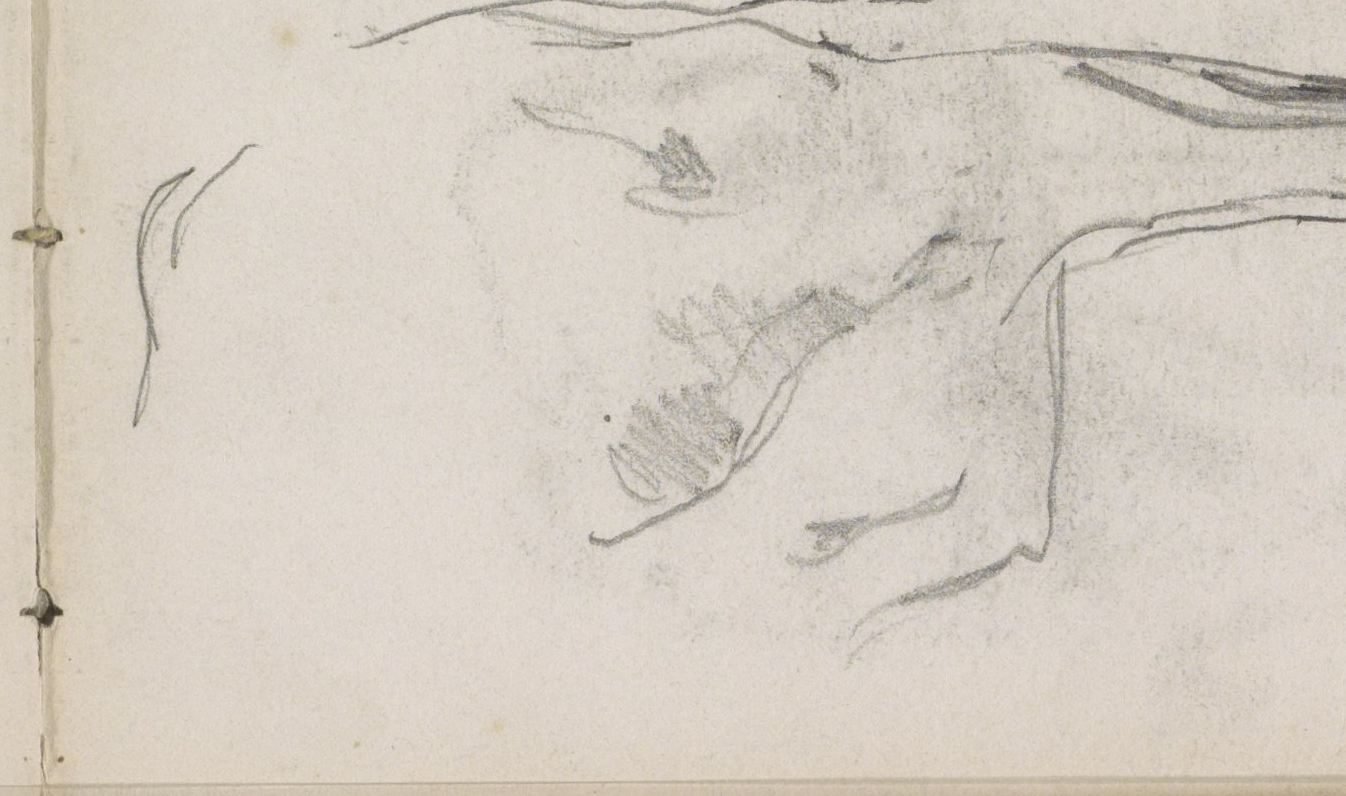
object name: sketchbook leaf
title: Paard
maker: george hendrik breitner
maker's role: draughtsman, painter, print maker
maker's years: 1857-1923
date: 1881-1883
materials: paper, pencil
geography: north brabant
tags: horse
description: Pagina 66 uit een schetsboek met 42 bladen.